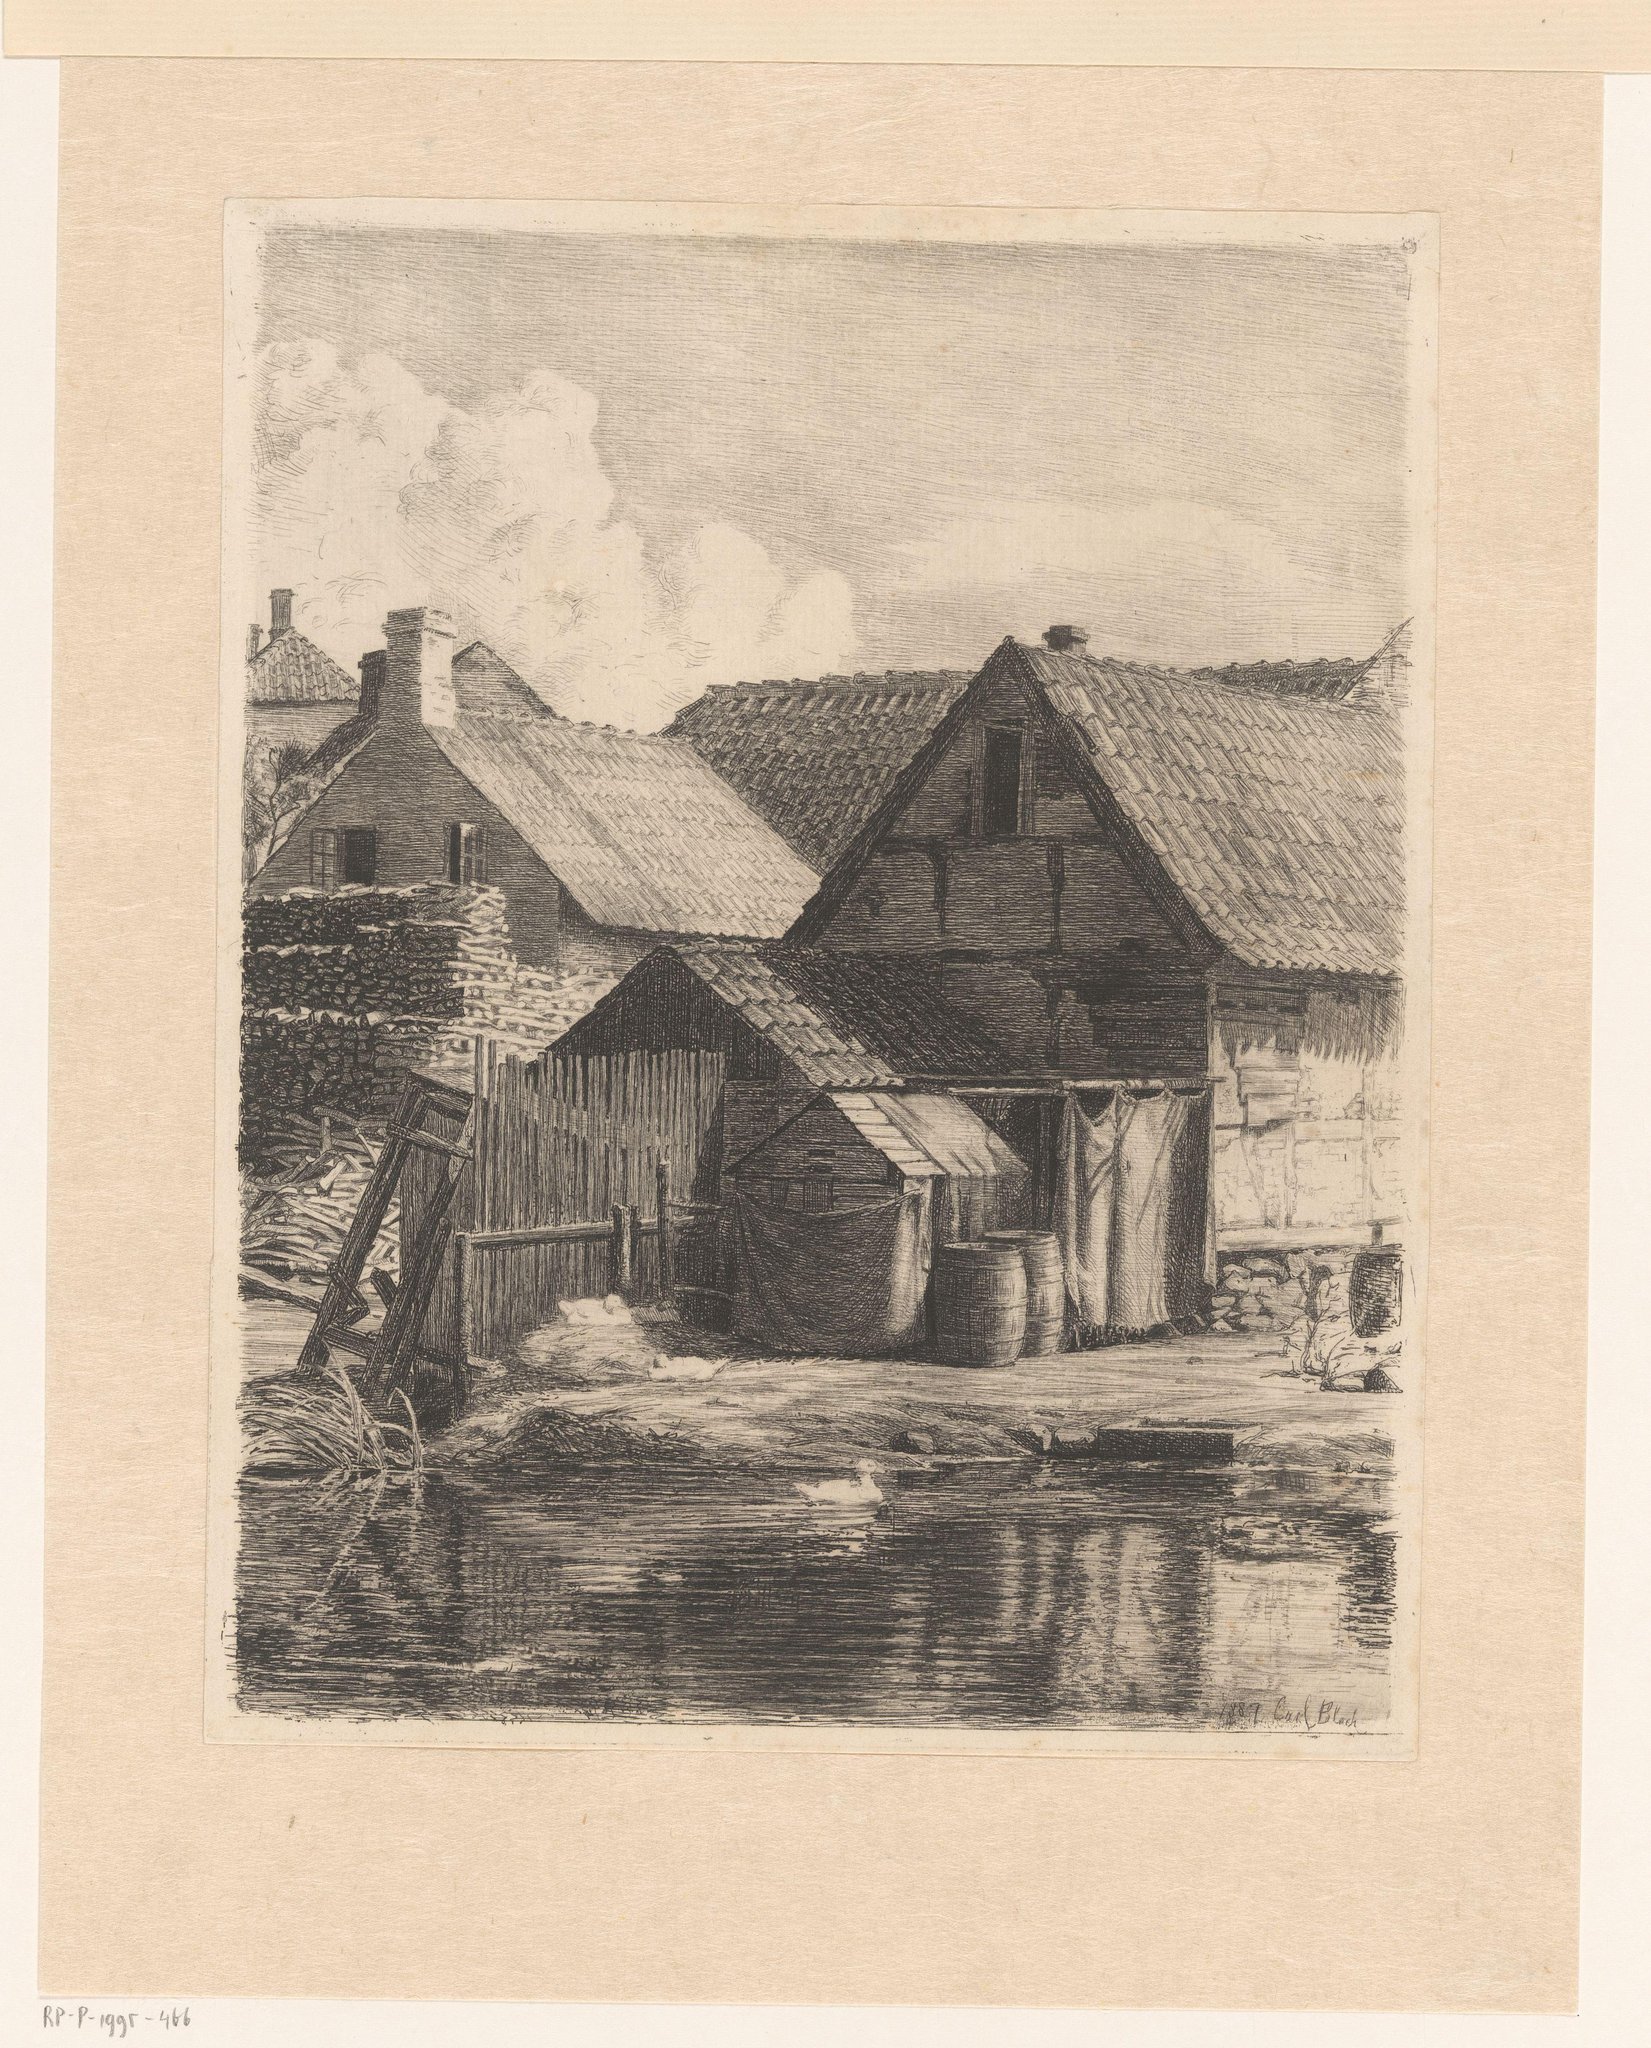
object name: print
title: Huizen met houtopslag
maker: carl bloch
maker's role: print maker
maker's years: 1834-1890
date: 1887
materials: paper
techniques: drypoint, etching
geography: scandinavia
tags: farm (building)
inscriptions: signature and date: ‘r.o. gesigneerd en gedateerd Carl Bloch 1887’, collector's mark: Lugt 2228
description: Achterkant van twee huizen met schuurtjes, aan een sloot. Links een houtopslag.